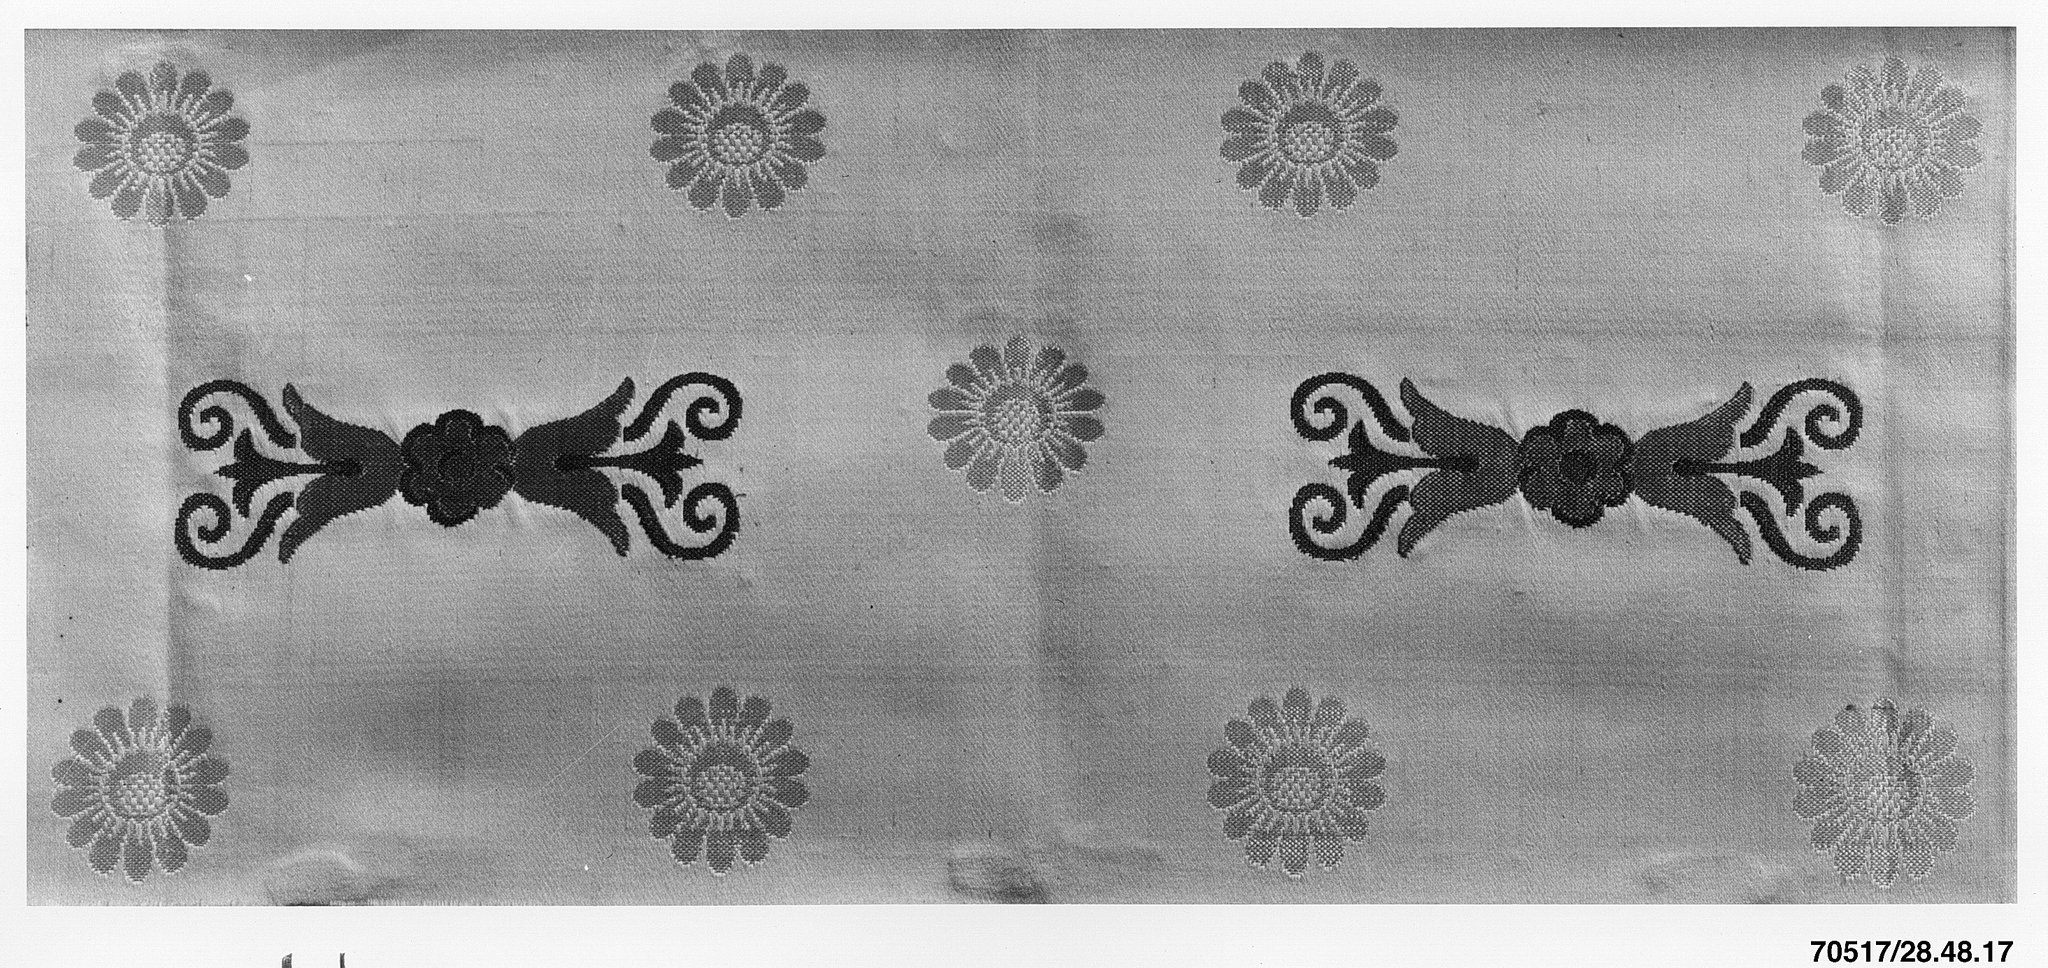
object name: piece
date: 1801-1900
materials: metal thread, silk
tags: flowers